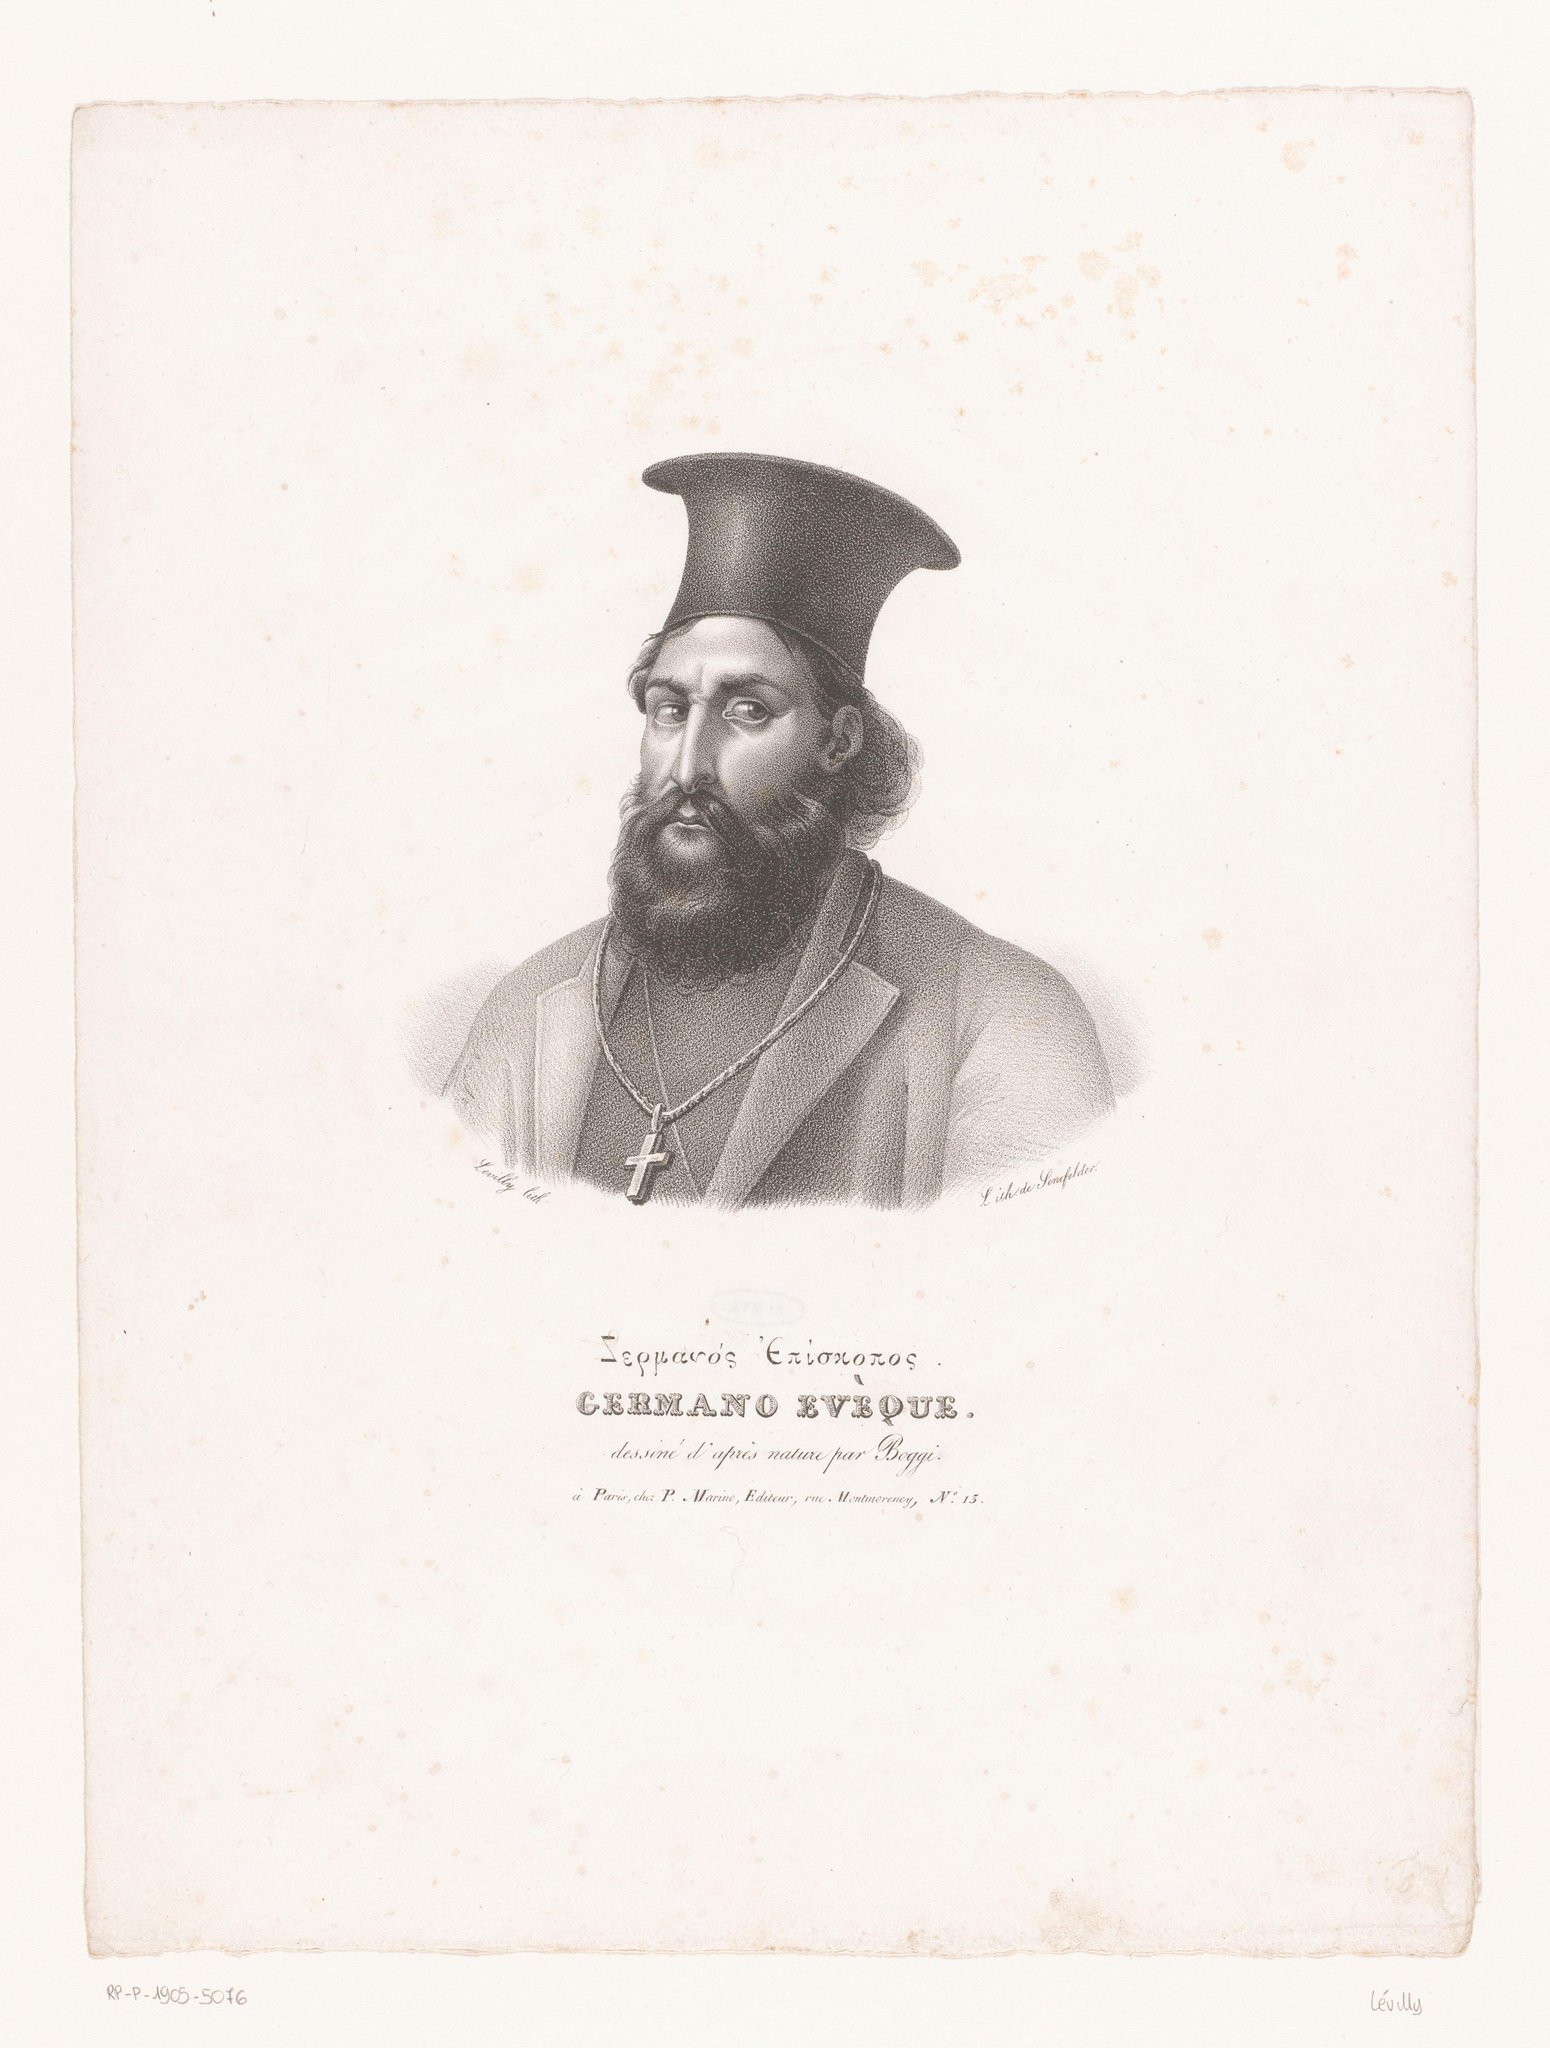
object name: print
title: Portret van metropoliet Germano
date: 1827-1829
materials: paper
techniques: lithograph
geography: paris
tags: clergyman, historical persons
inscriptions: collector's mark: Lugt 2228